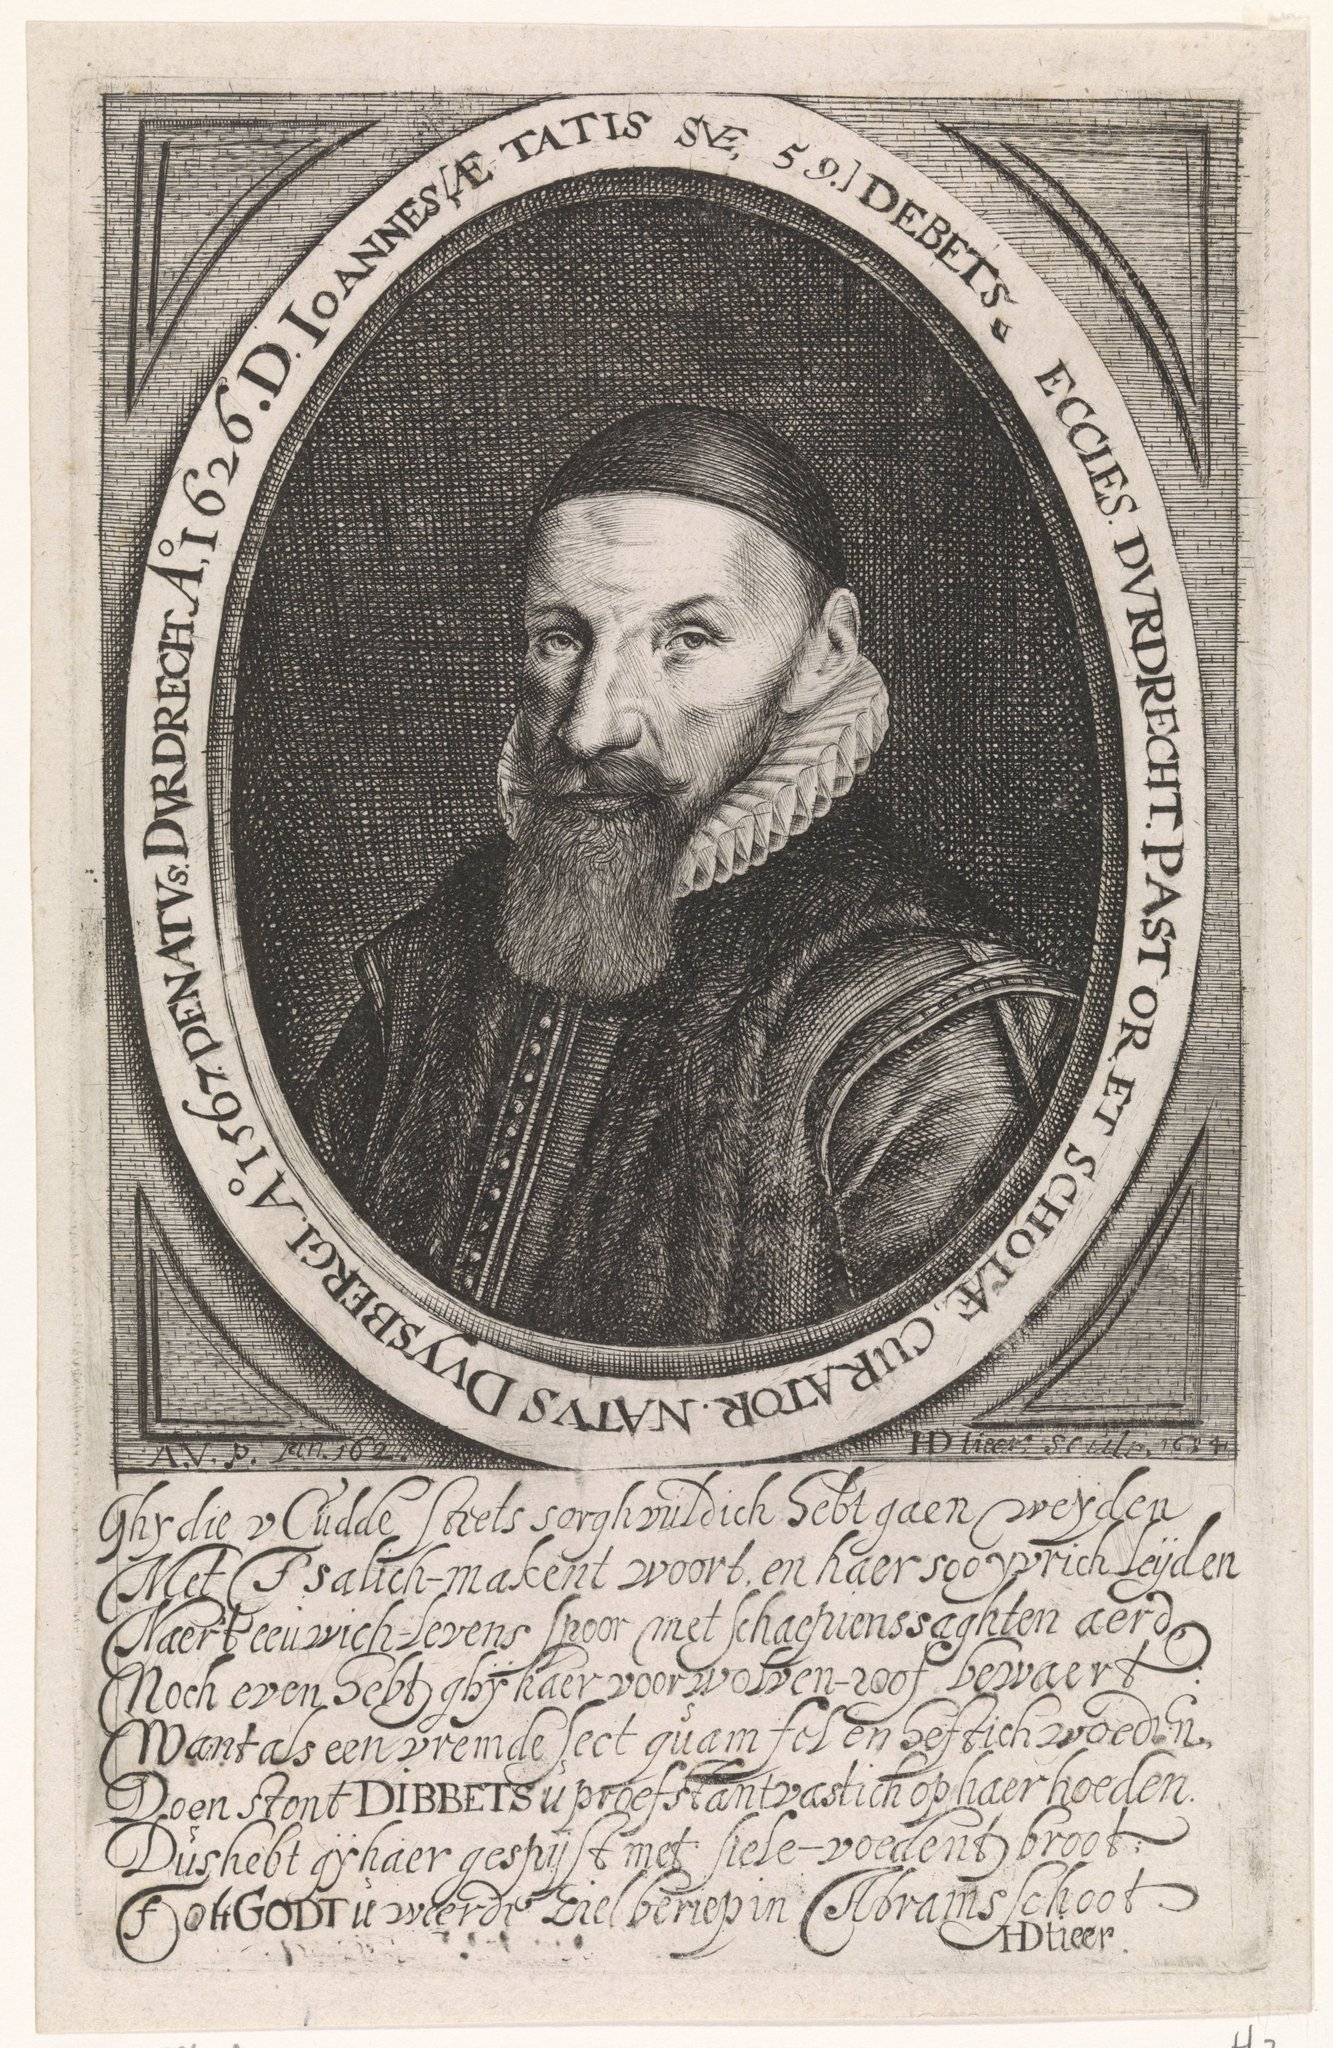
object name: print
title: Portret van Johannes Dibbets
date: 1634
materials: paper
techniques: etching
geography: netherlands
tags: duisburg, predikant, johannes dibbets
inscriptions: collector's mark: Lugt 2228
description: Portret van Johannes Dibbets, predikant te Dordrecht, op 59-jarige leeftijd. Onderaan een achtregelig vers in het Nederlands.